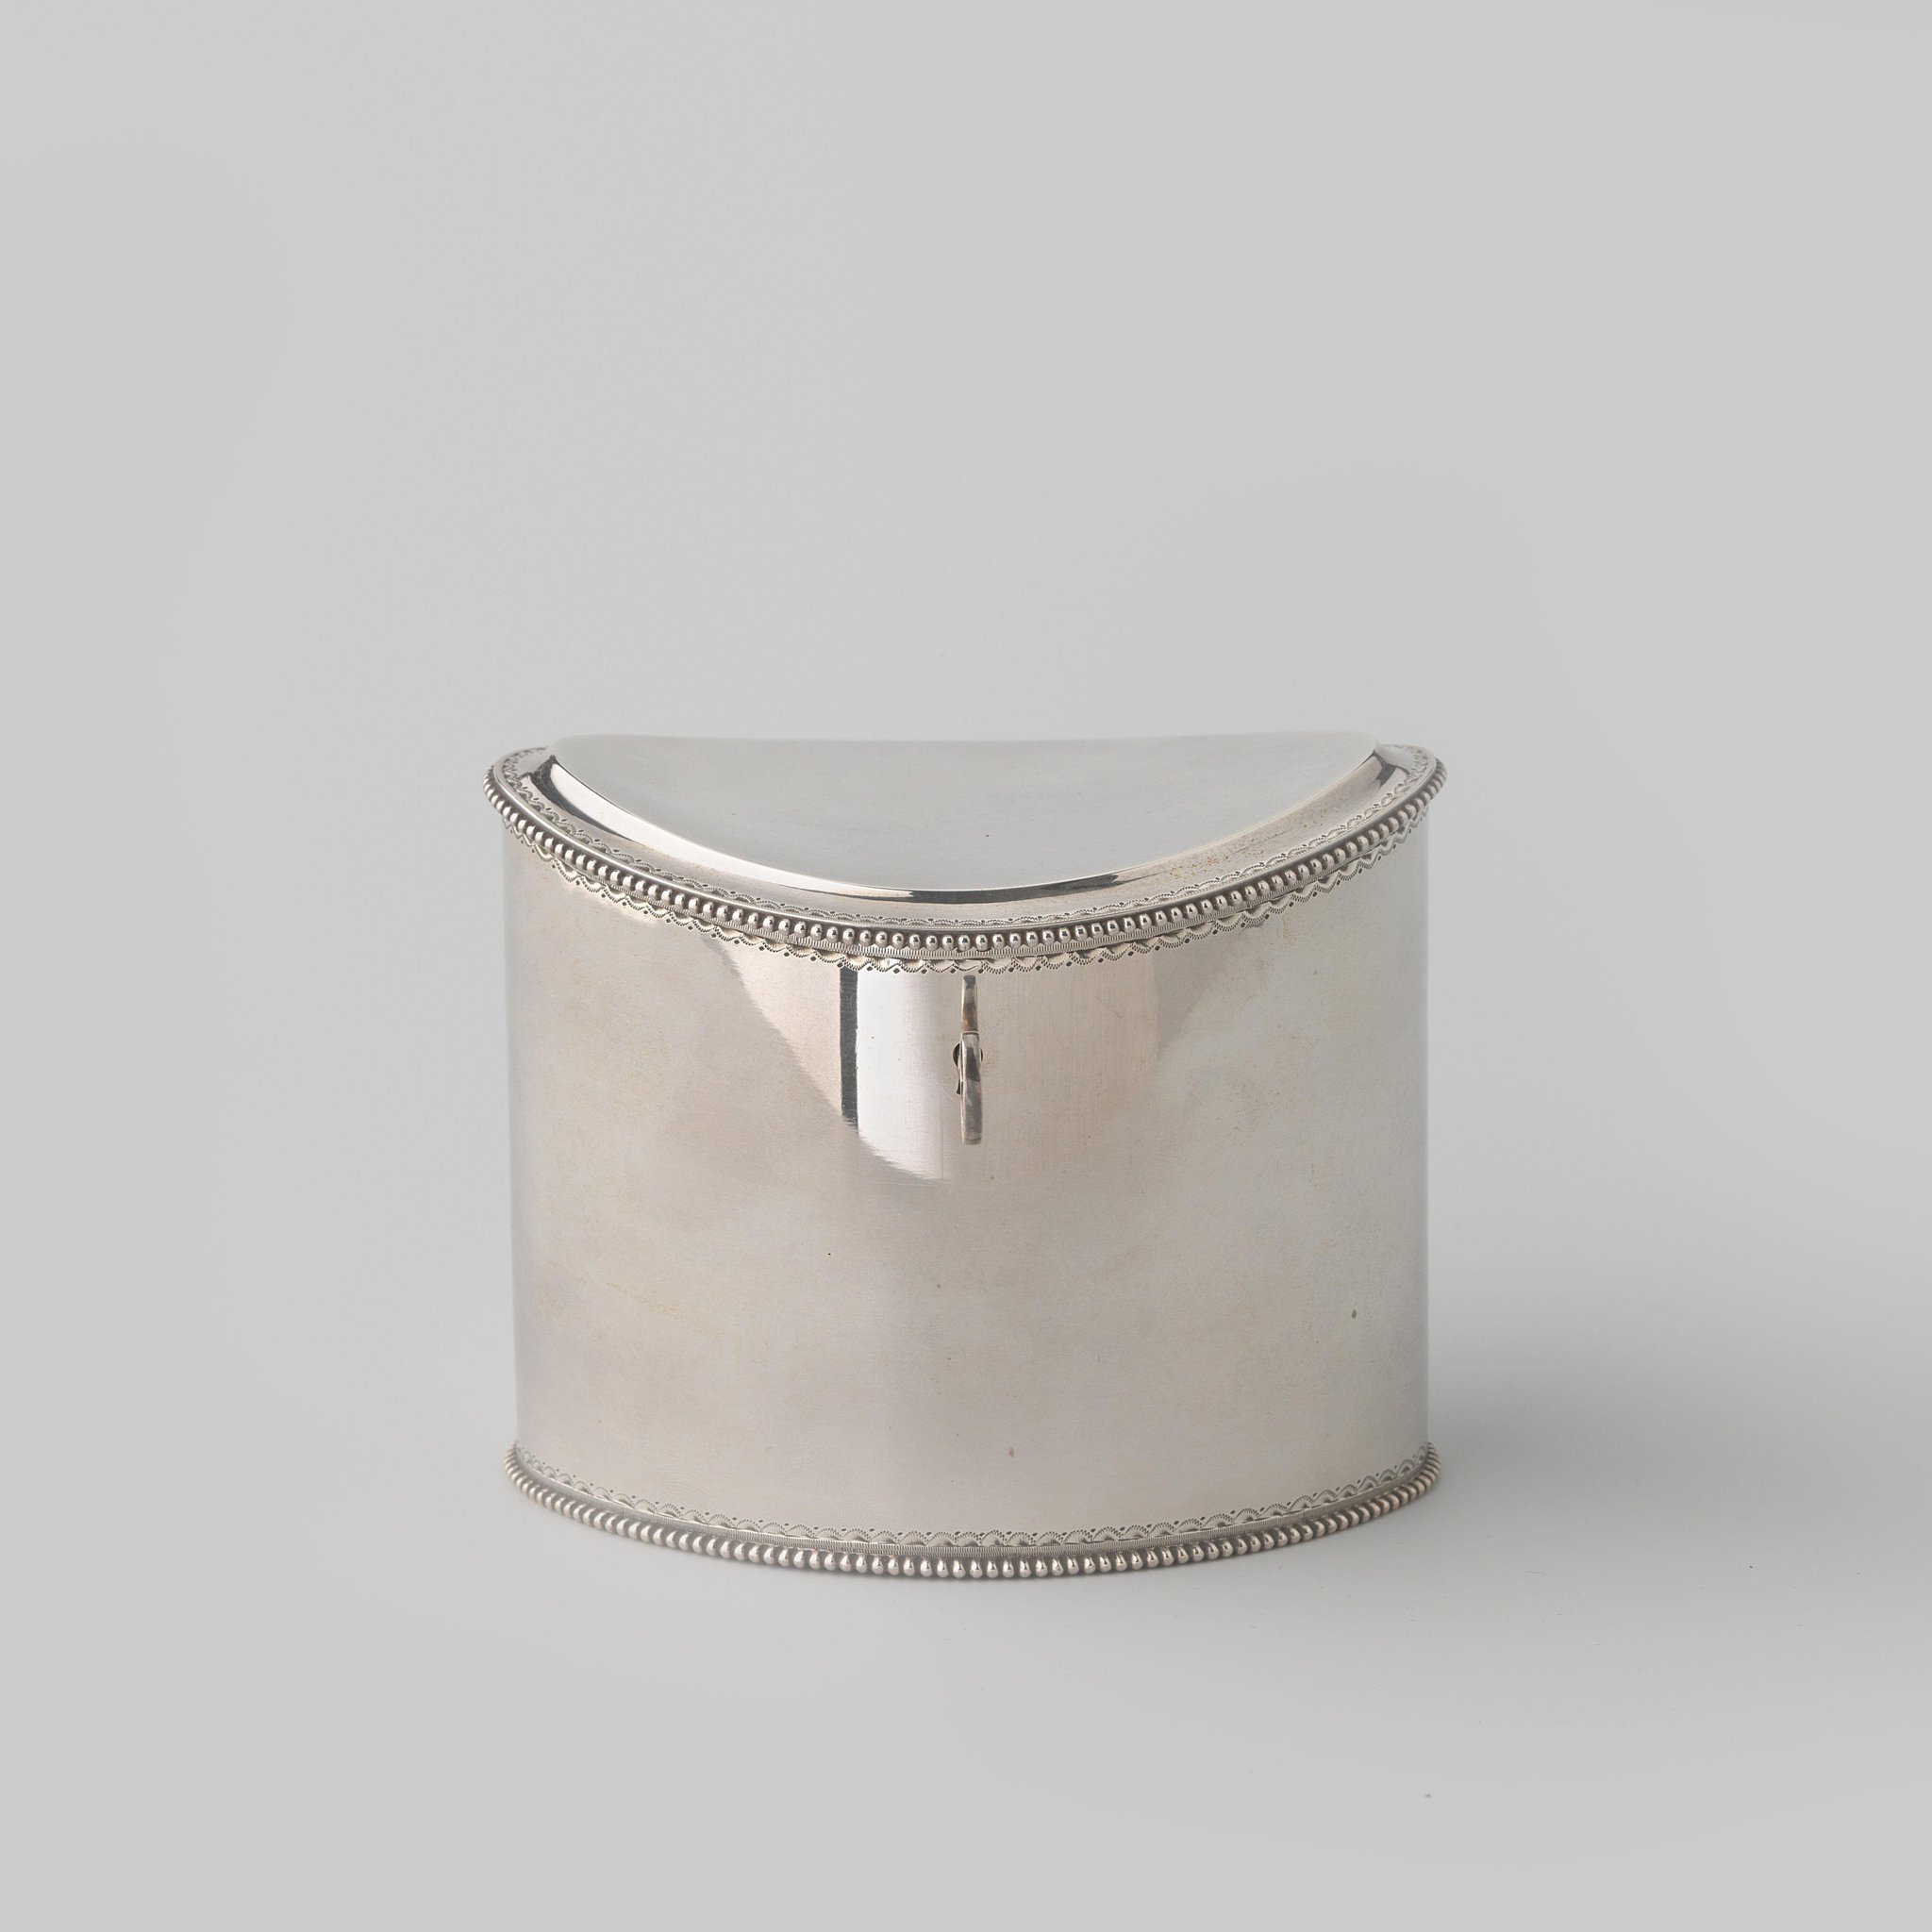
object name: tea caddy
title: Theebus, spitsovaal, met parelranden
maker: jan buijsen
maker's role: silversmith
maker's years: 1749-1813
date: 1807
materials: iron, silver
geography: amsterdam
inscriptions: maker's mark, date letter: ‘Y’, town mark, alloy mark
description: Tea caddy. Silver. Amsterdam, 1804, by Jan Buysen.